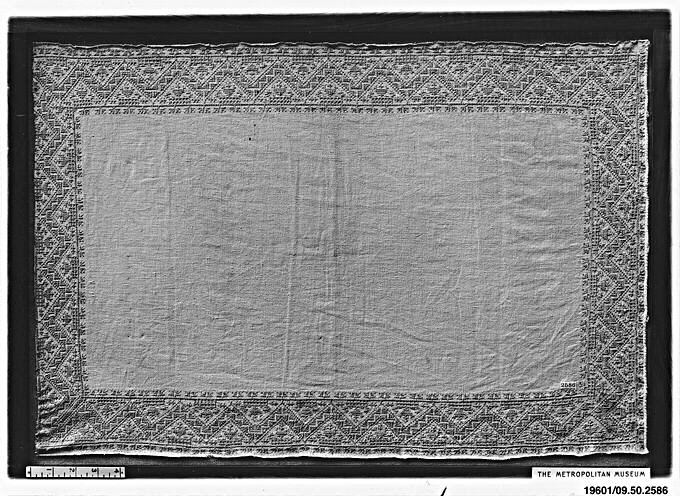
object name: panel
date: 1701-1800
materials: linen, silk